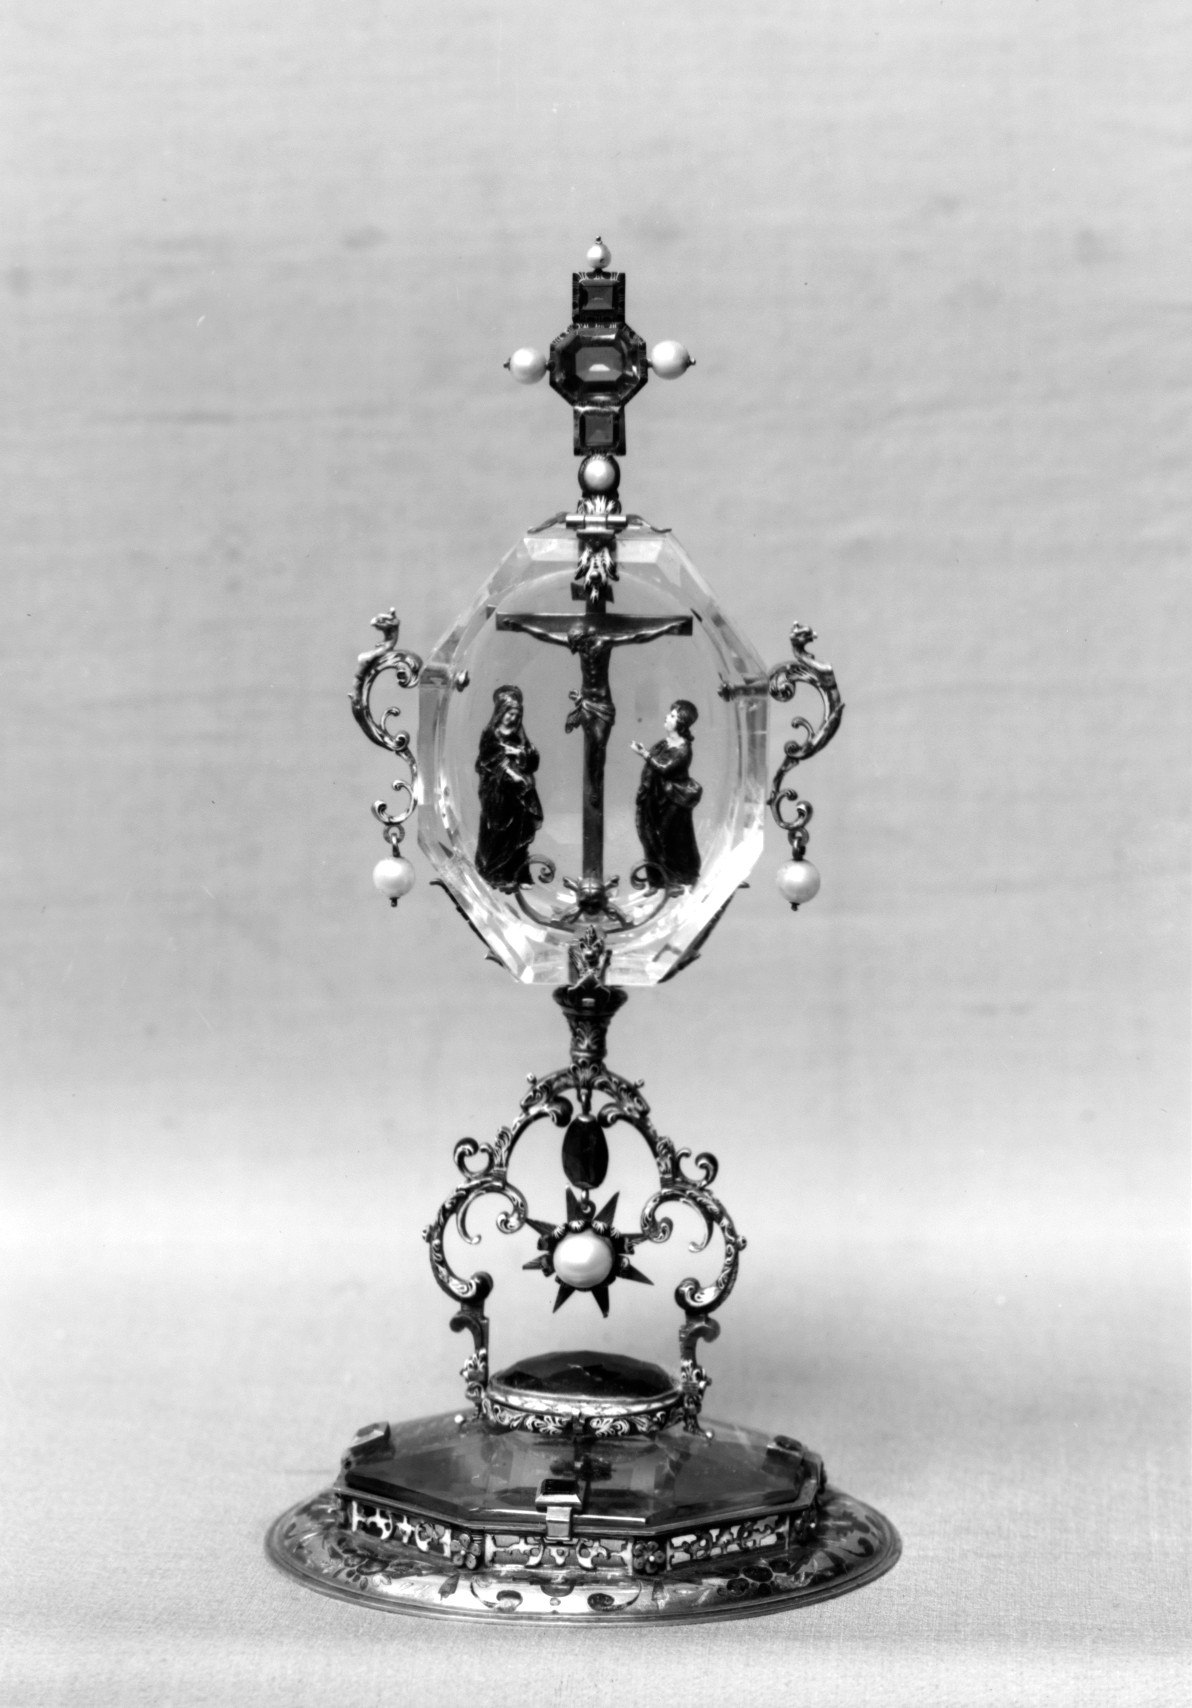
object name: shrine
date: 1801-1900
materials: gemstone, enamel, gold, pearl, quartz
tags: crucifixion